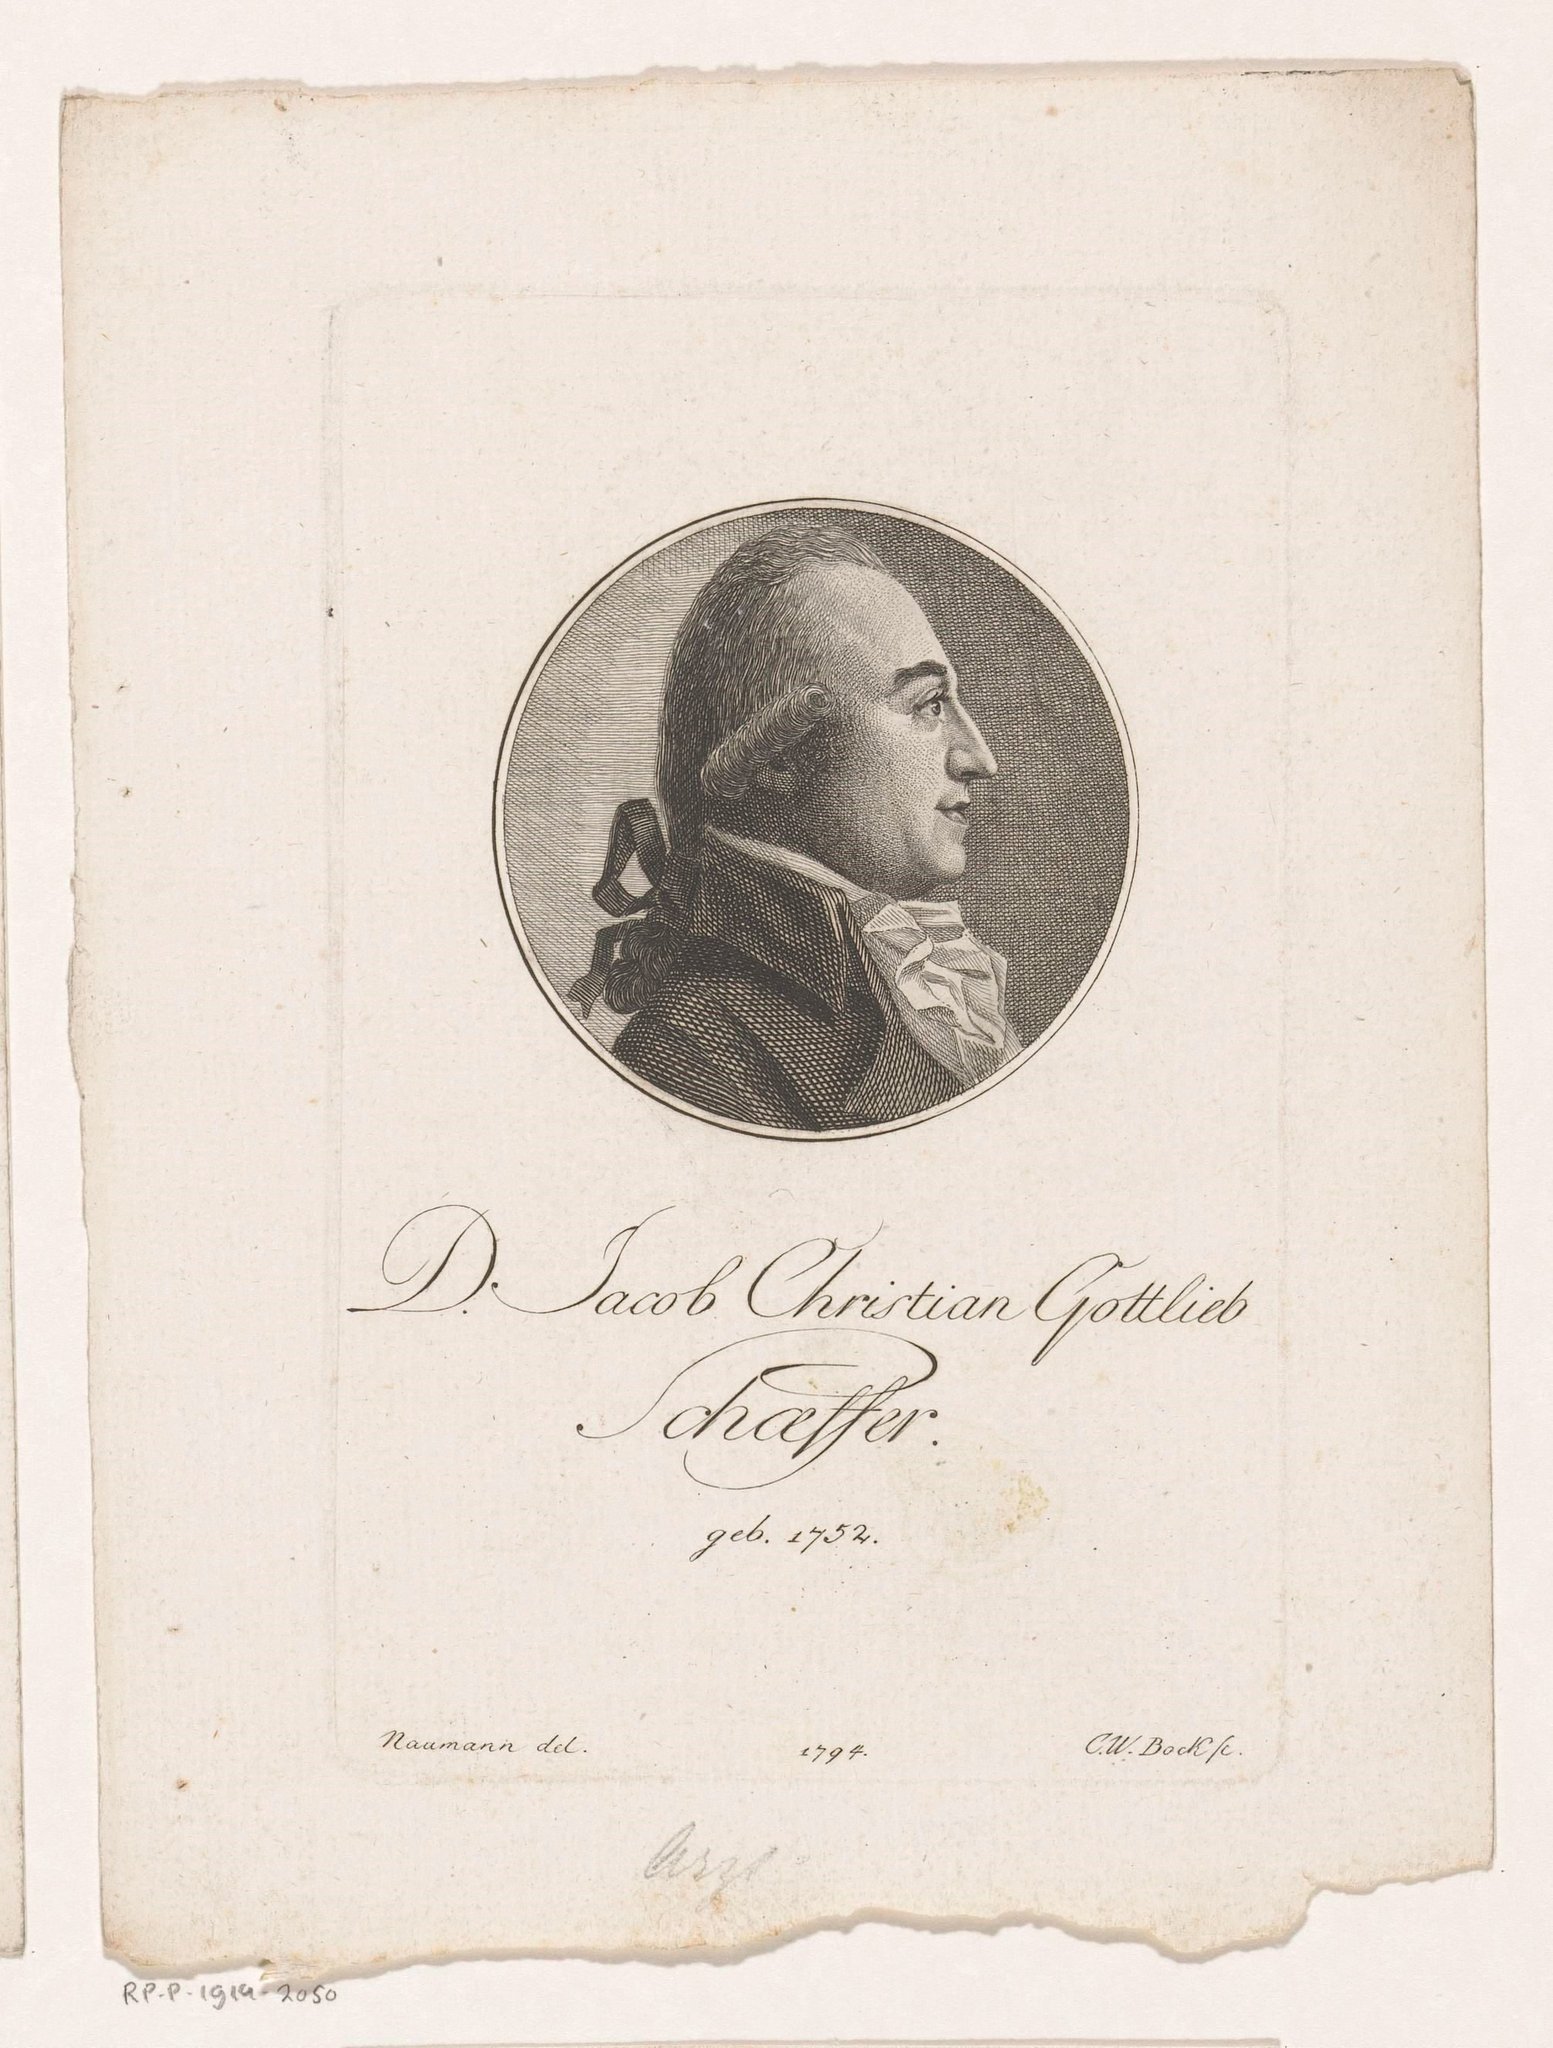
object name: print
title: Portret van Jacob Christian Gottlieb von Schaeffer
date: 1794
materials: paper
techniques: engraving, etching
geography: nuremberg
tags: historical persons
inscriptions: collector's mark: Lugt 2228